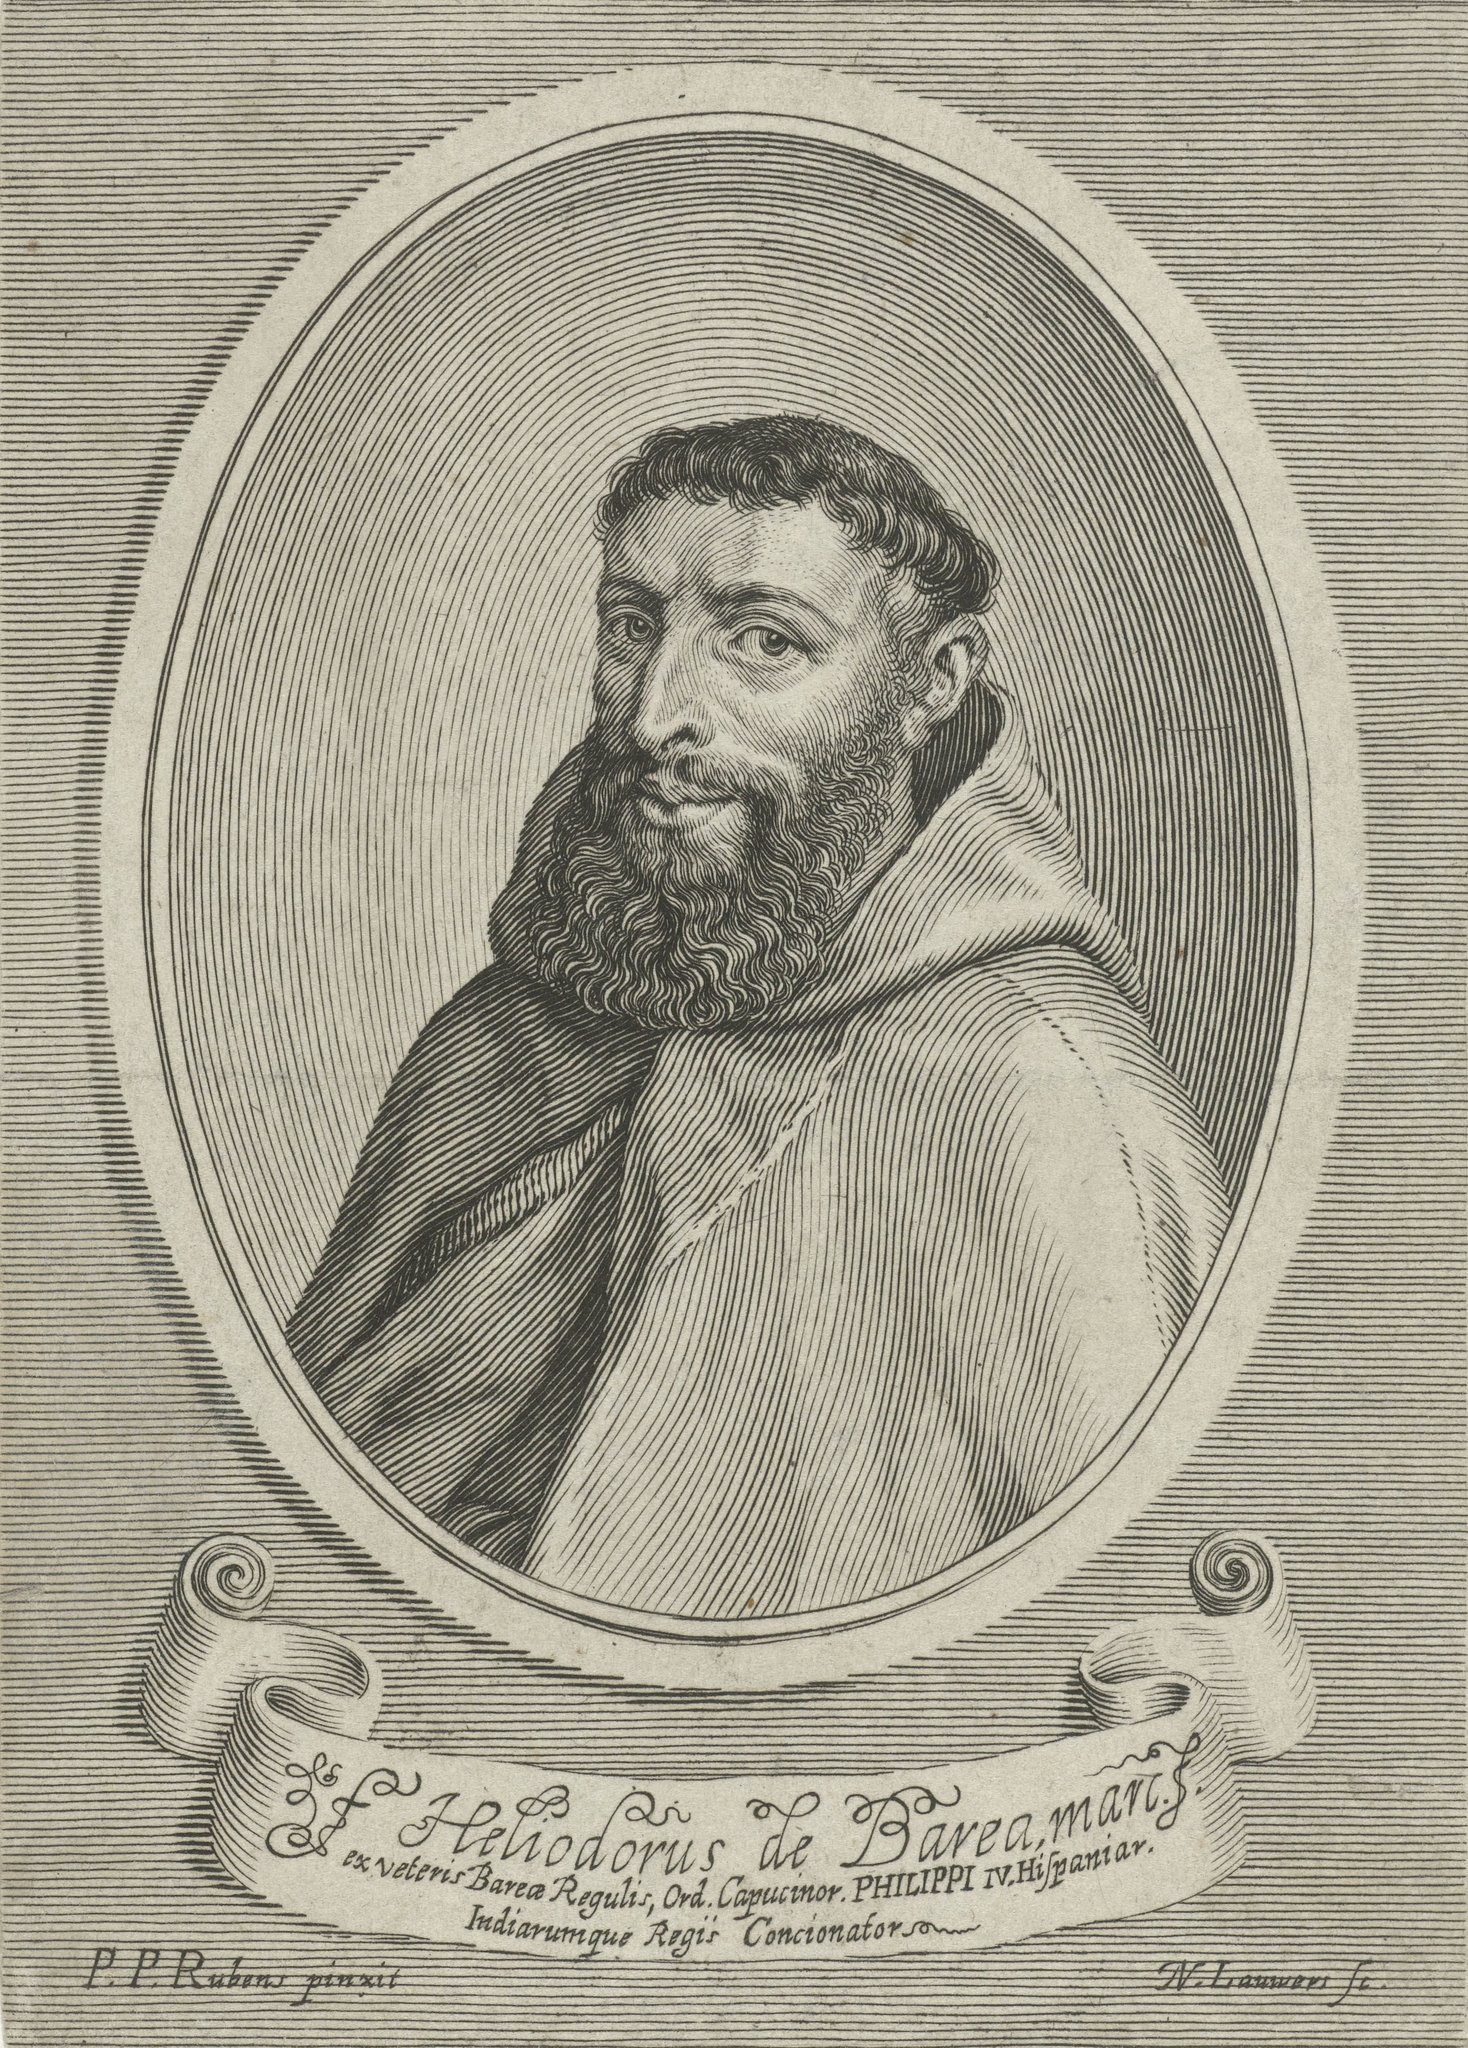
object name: print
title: Portret van Heliodor de Barea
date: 1619-1652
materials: paper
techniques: engraving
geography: antwerp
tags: minderbroeder, heliodor de barea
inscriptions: collector's mark: Lugt 2228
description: Portretbuste in ovaal naar links van de Spaanse martelaar Heliodor de Barea, gehuld in een habijt. Op een banderol onder het ovaal staat de naam van de geportretteerde, gevolgd door een tweeregelige tekst in Latijn.